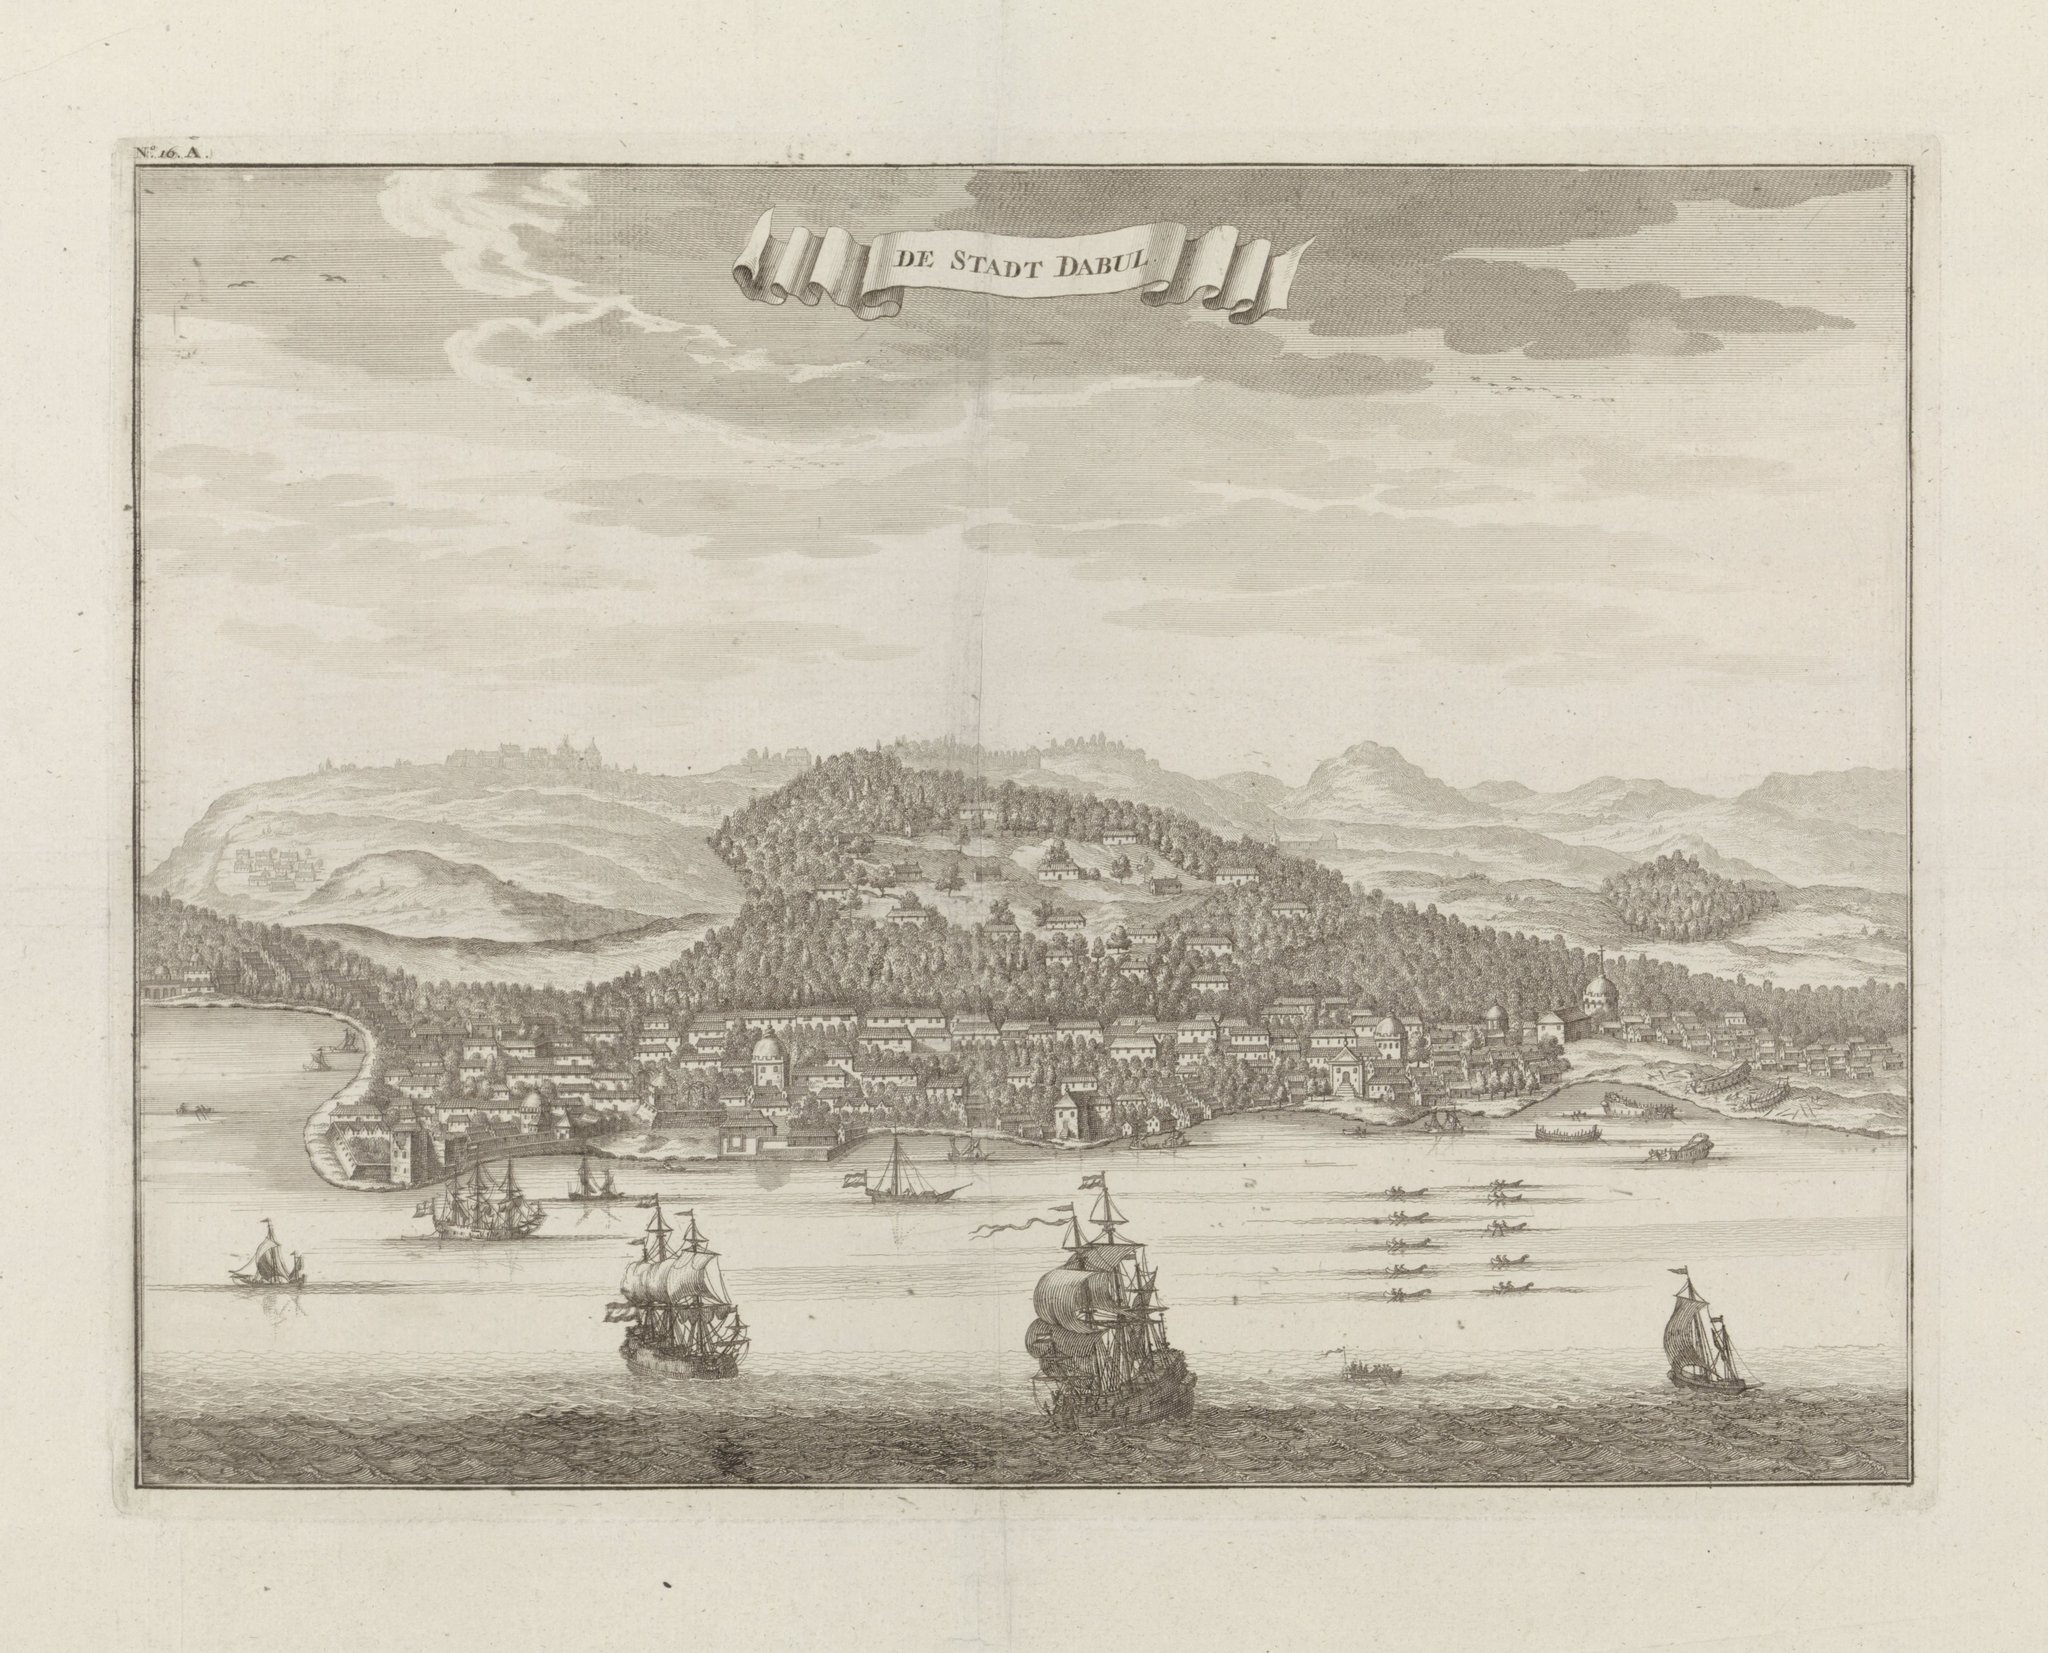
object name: print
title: Gezicht op de stad Dabul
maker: frederik ottens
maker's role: draughtsman, print maker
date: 1717-1770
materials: paper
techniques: etching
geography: amsterdam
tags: city-view in general; 'veduta'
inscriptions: collector's mark: Lugt 2228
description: Illustratie voor: F. Valentyn, Oud en nieuw Oost-Indiën, vervattende een naaukeurige en uitvoerige verhandelinge van Nederlands mogentheyd in die gewesten. Dordrecht, J. van Braam and Amsterdam, G. onder de Linden booksellers, 1724.